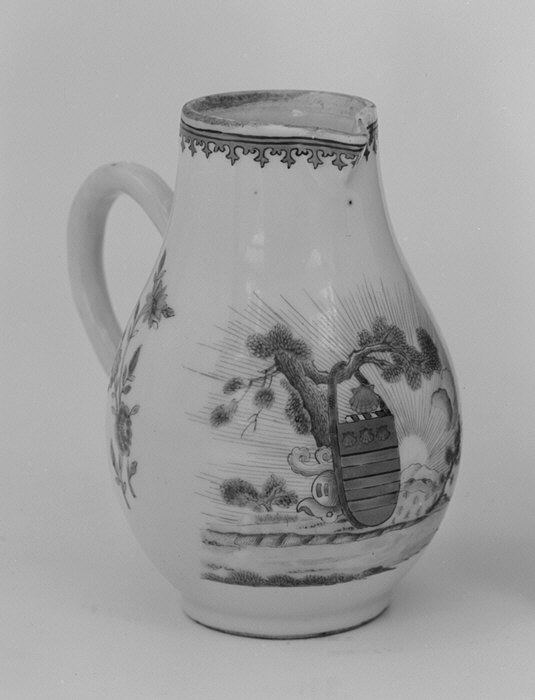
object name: cream jug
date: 1760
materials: hard paste porcelain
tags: trees